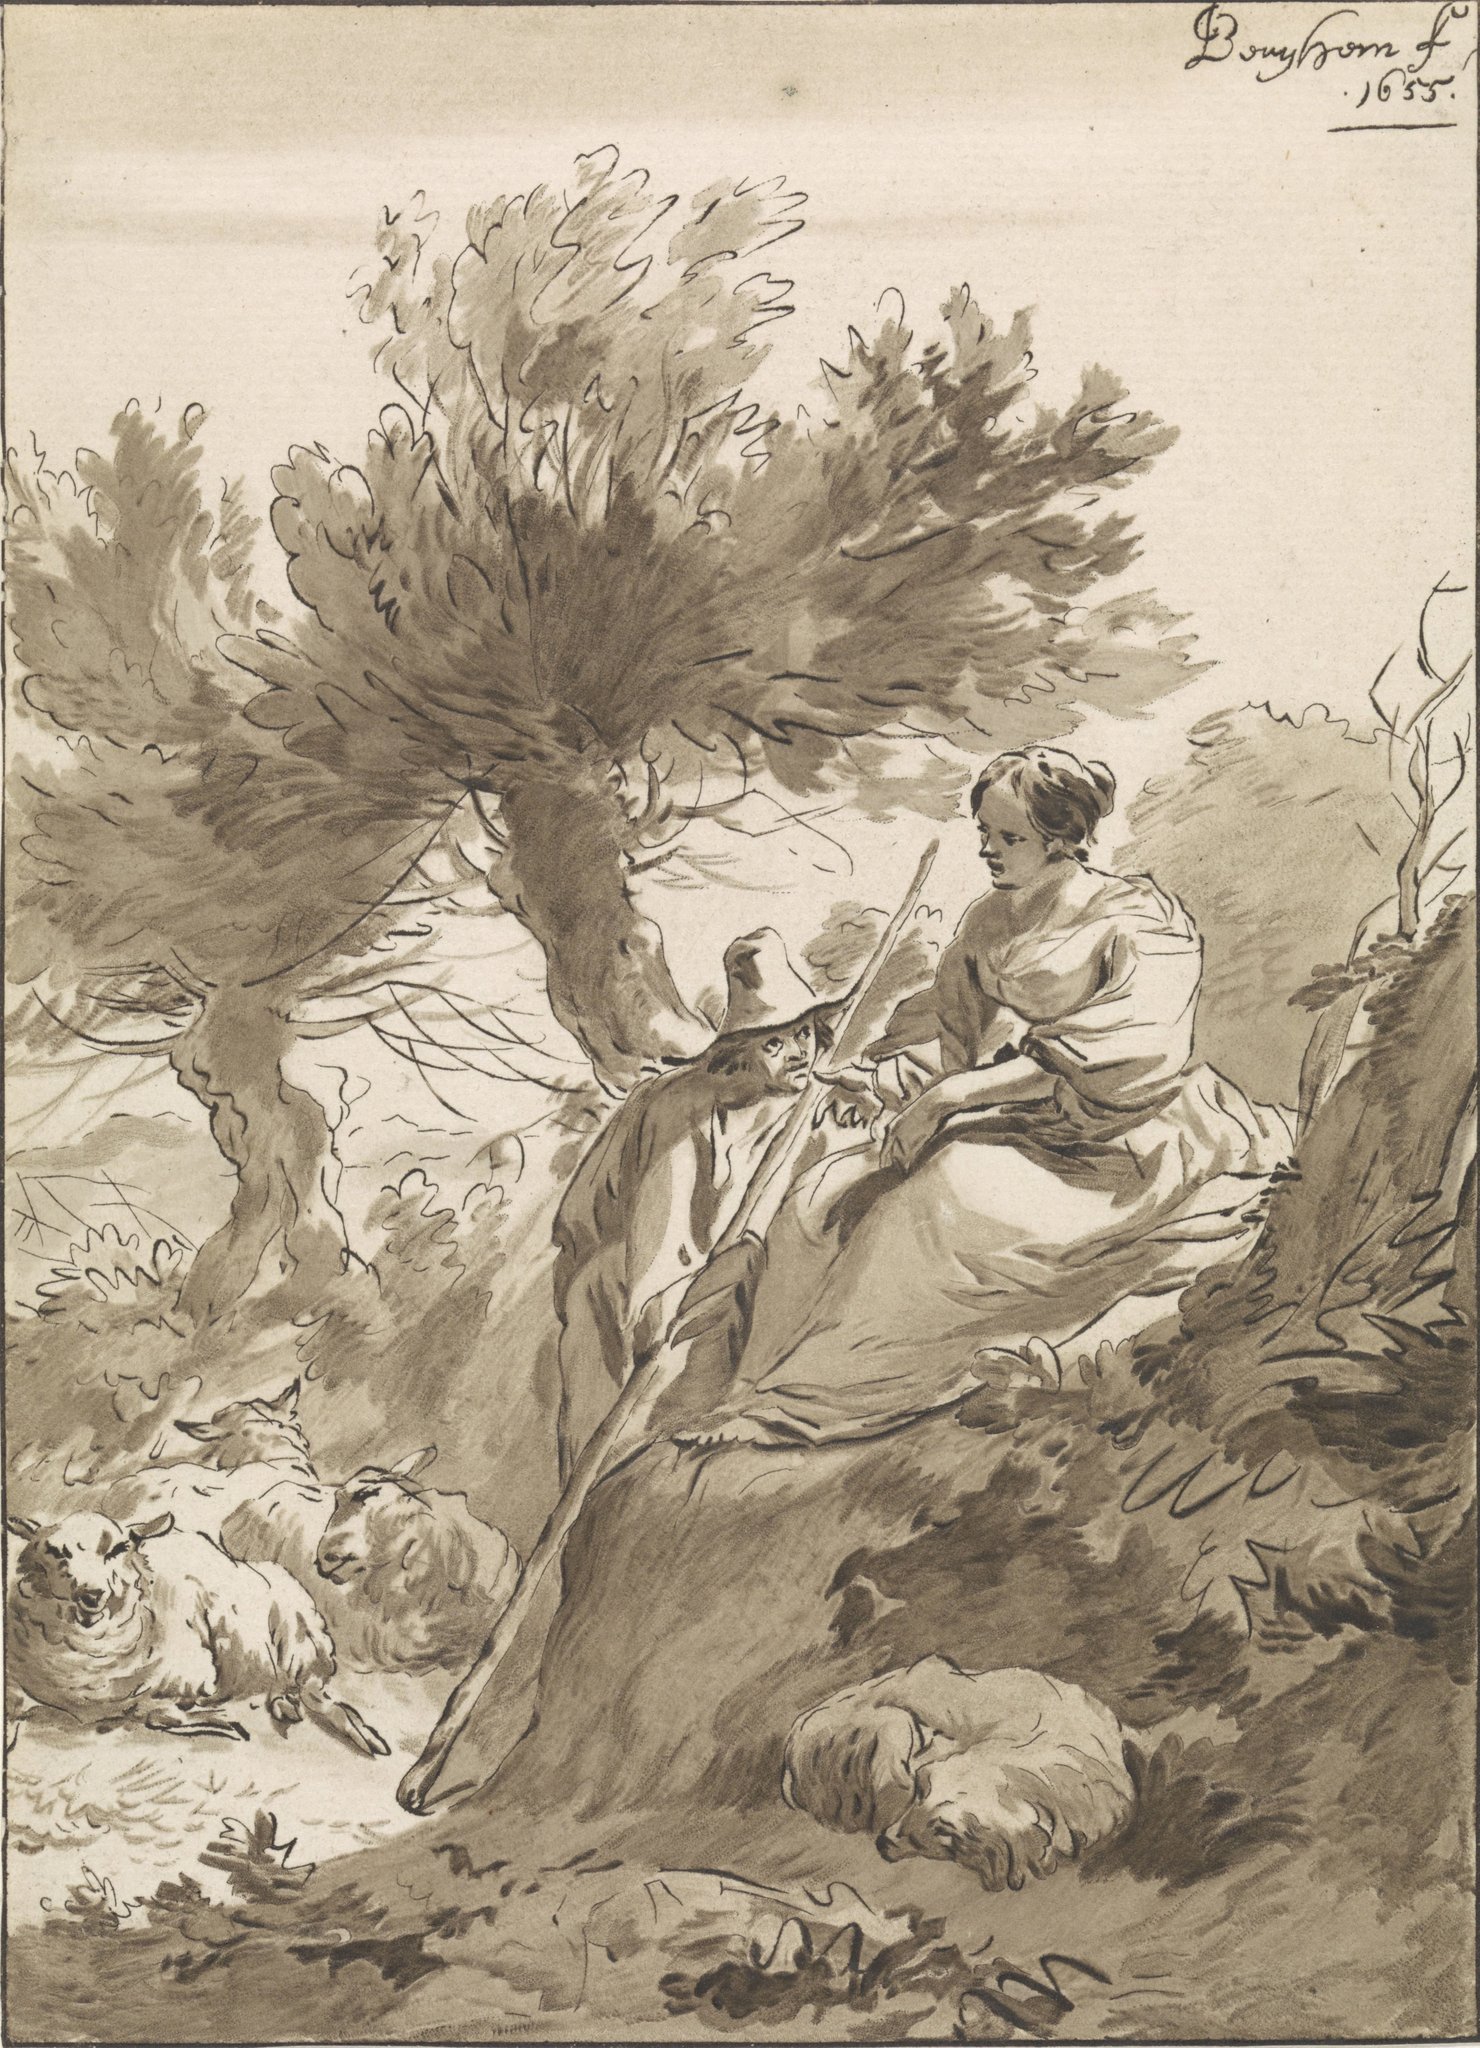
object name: print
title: Landschap met herder en herderin en hun schapen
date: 1655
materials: paper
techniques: print drawing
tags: landscapes, herding, herdsman, herdswoman, shepherd, shepherdess, cowherd, etc., sheep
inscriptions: collector's mark: Lugt 240